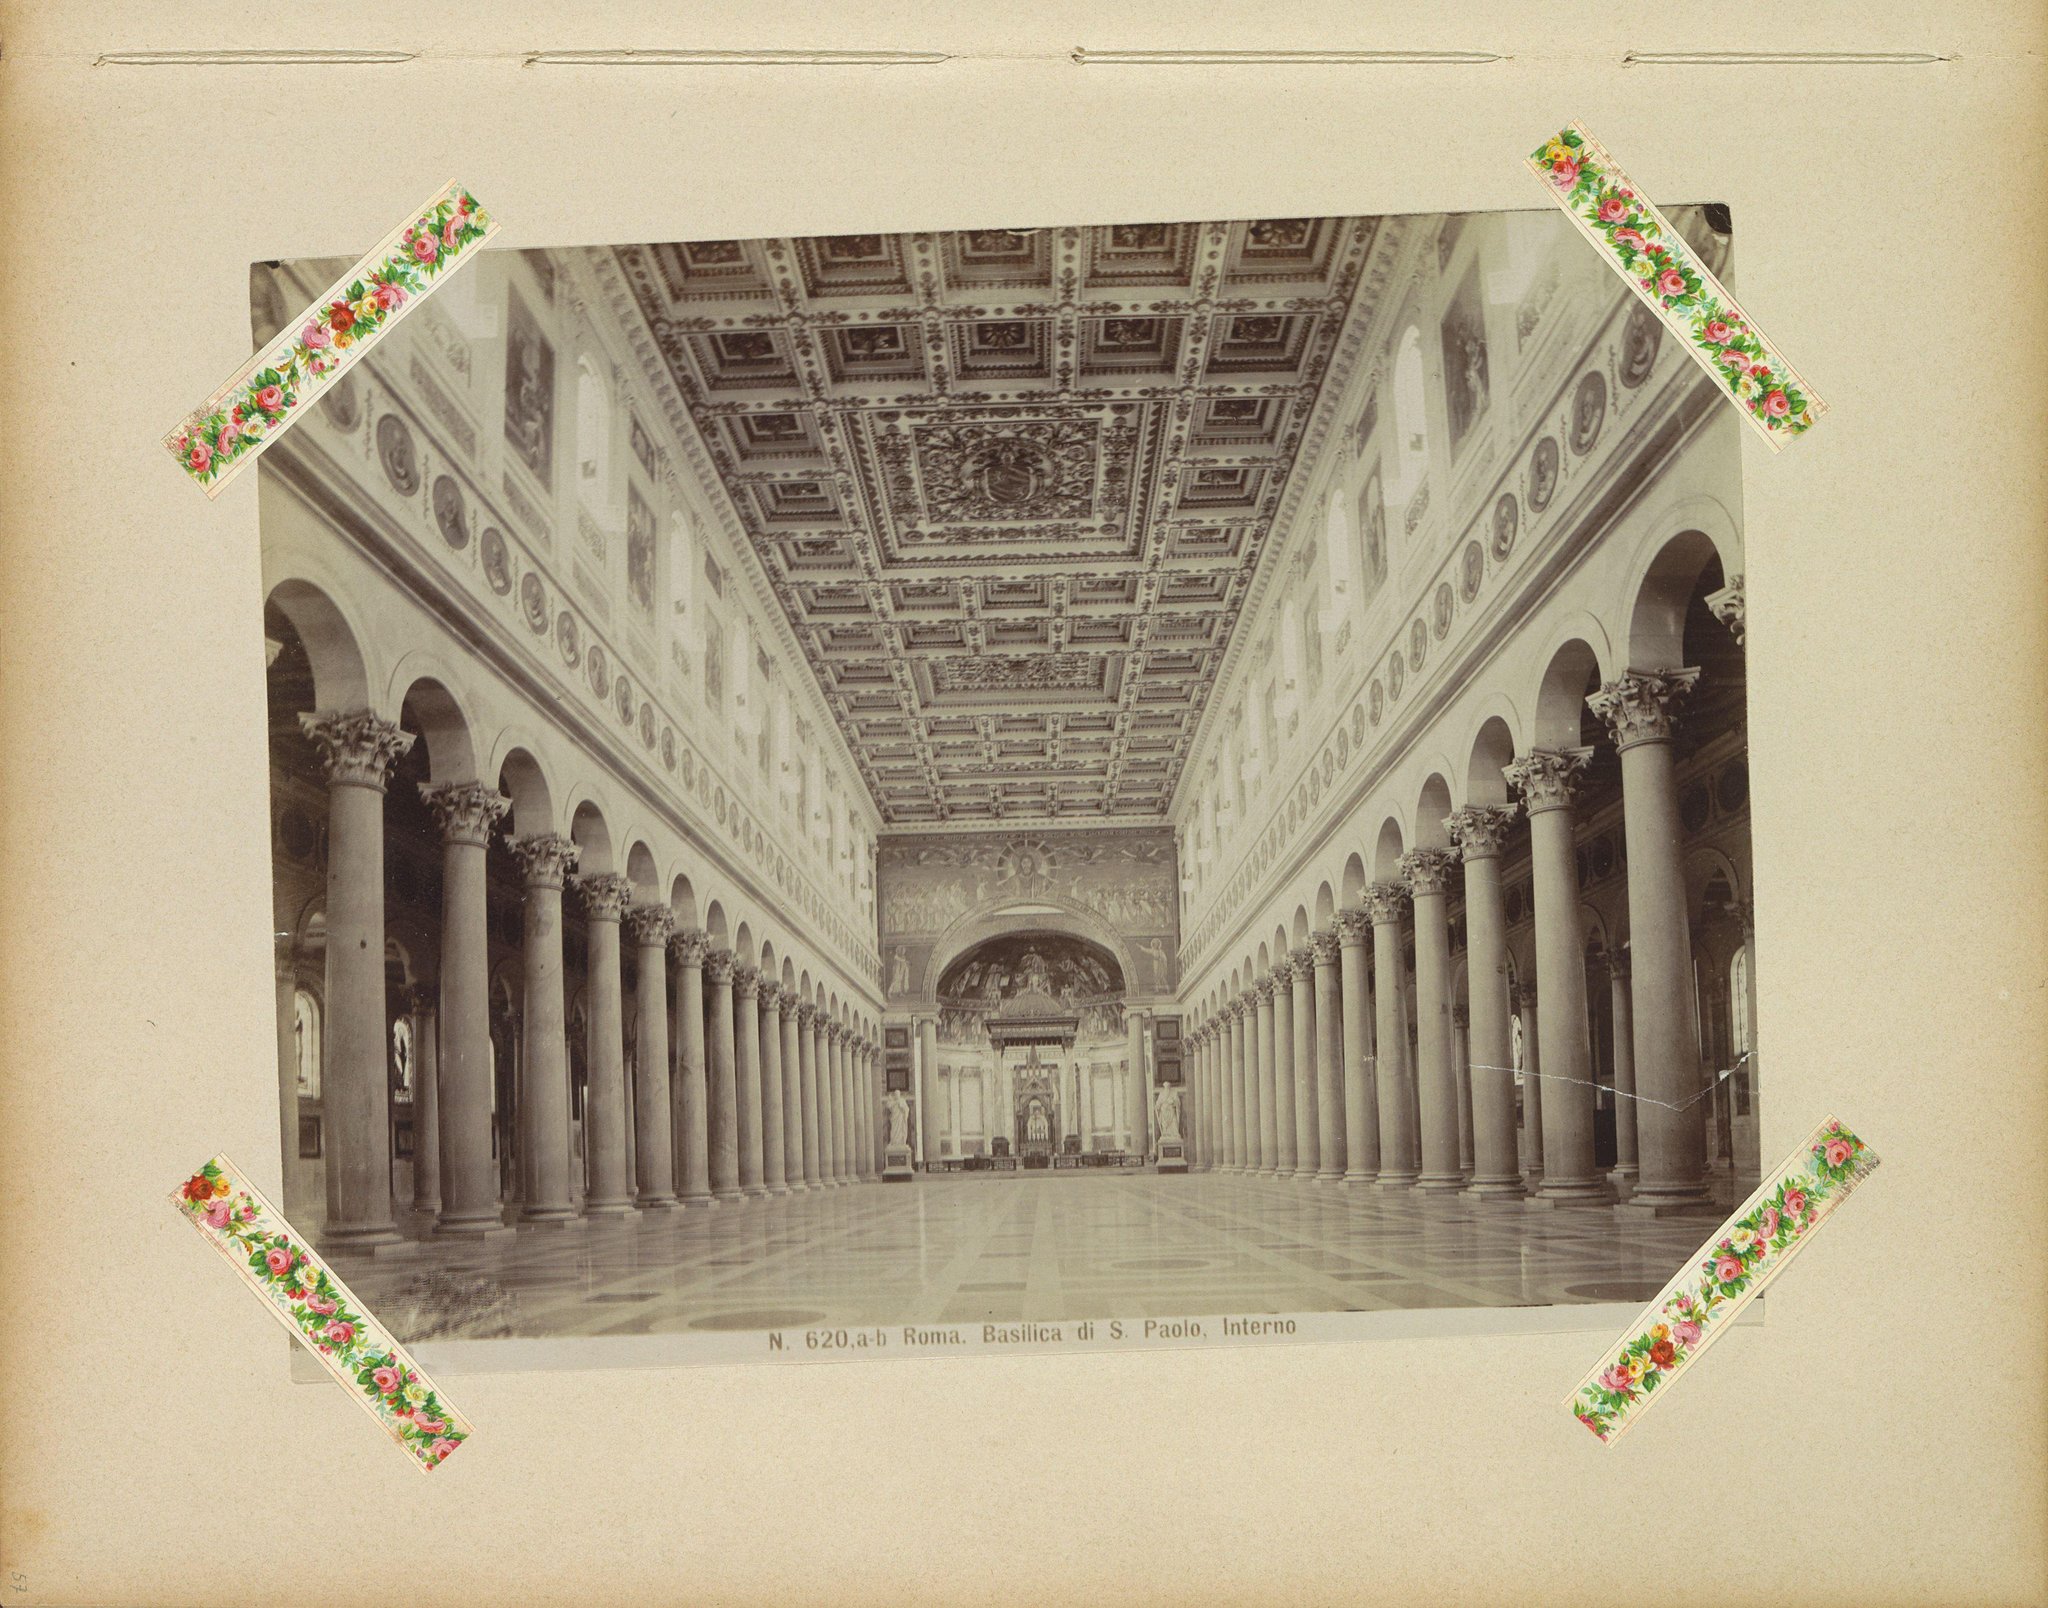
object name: photograph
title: Interieur van de Basiliek van Sint-Paulus buiten de Muren in Rome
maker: Anonymous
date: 1860-1900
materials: photographic support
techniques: albumen print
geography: sint-paulus buiten de muren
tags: colonnade, interior of church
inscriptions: number: ‘620,a-b’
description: Onderdeel van Fotoalbum met opnames van bezienswaardigheden in Italiaanse steden en van kunstwerken.